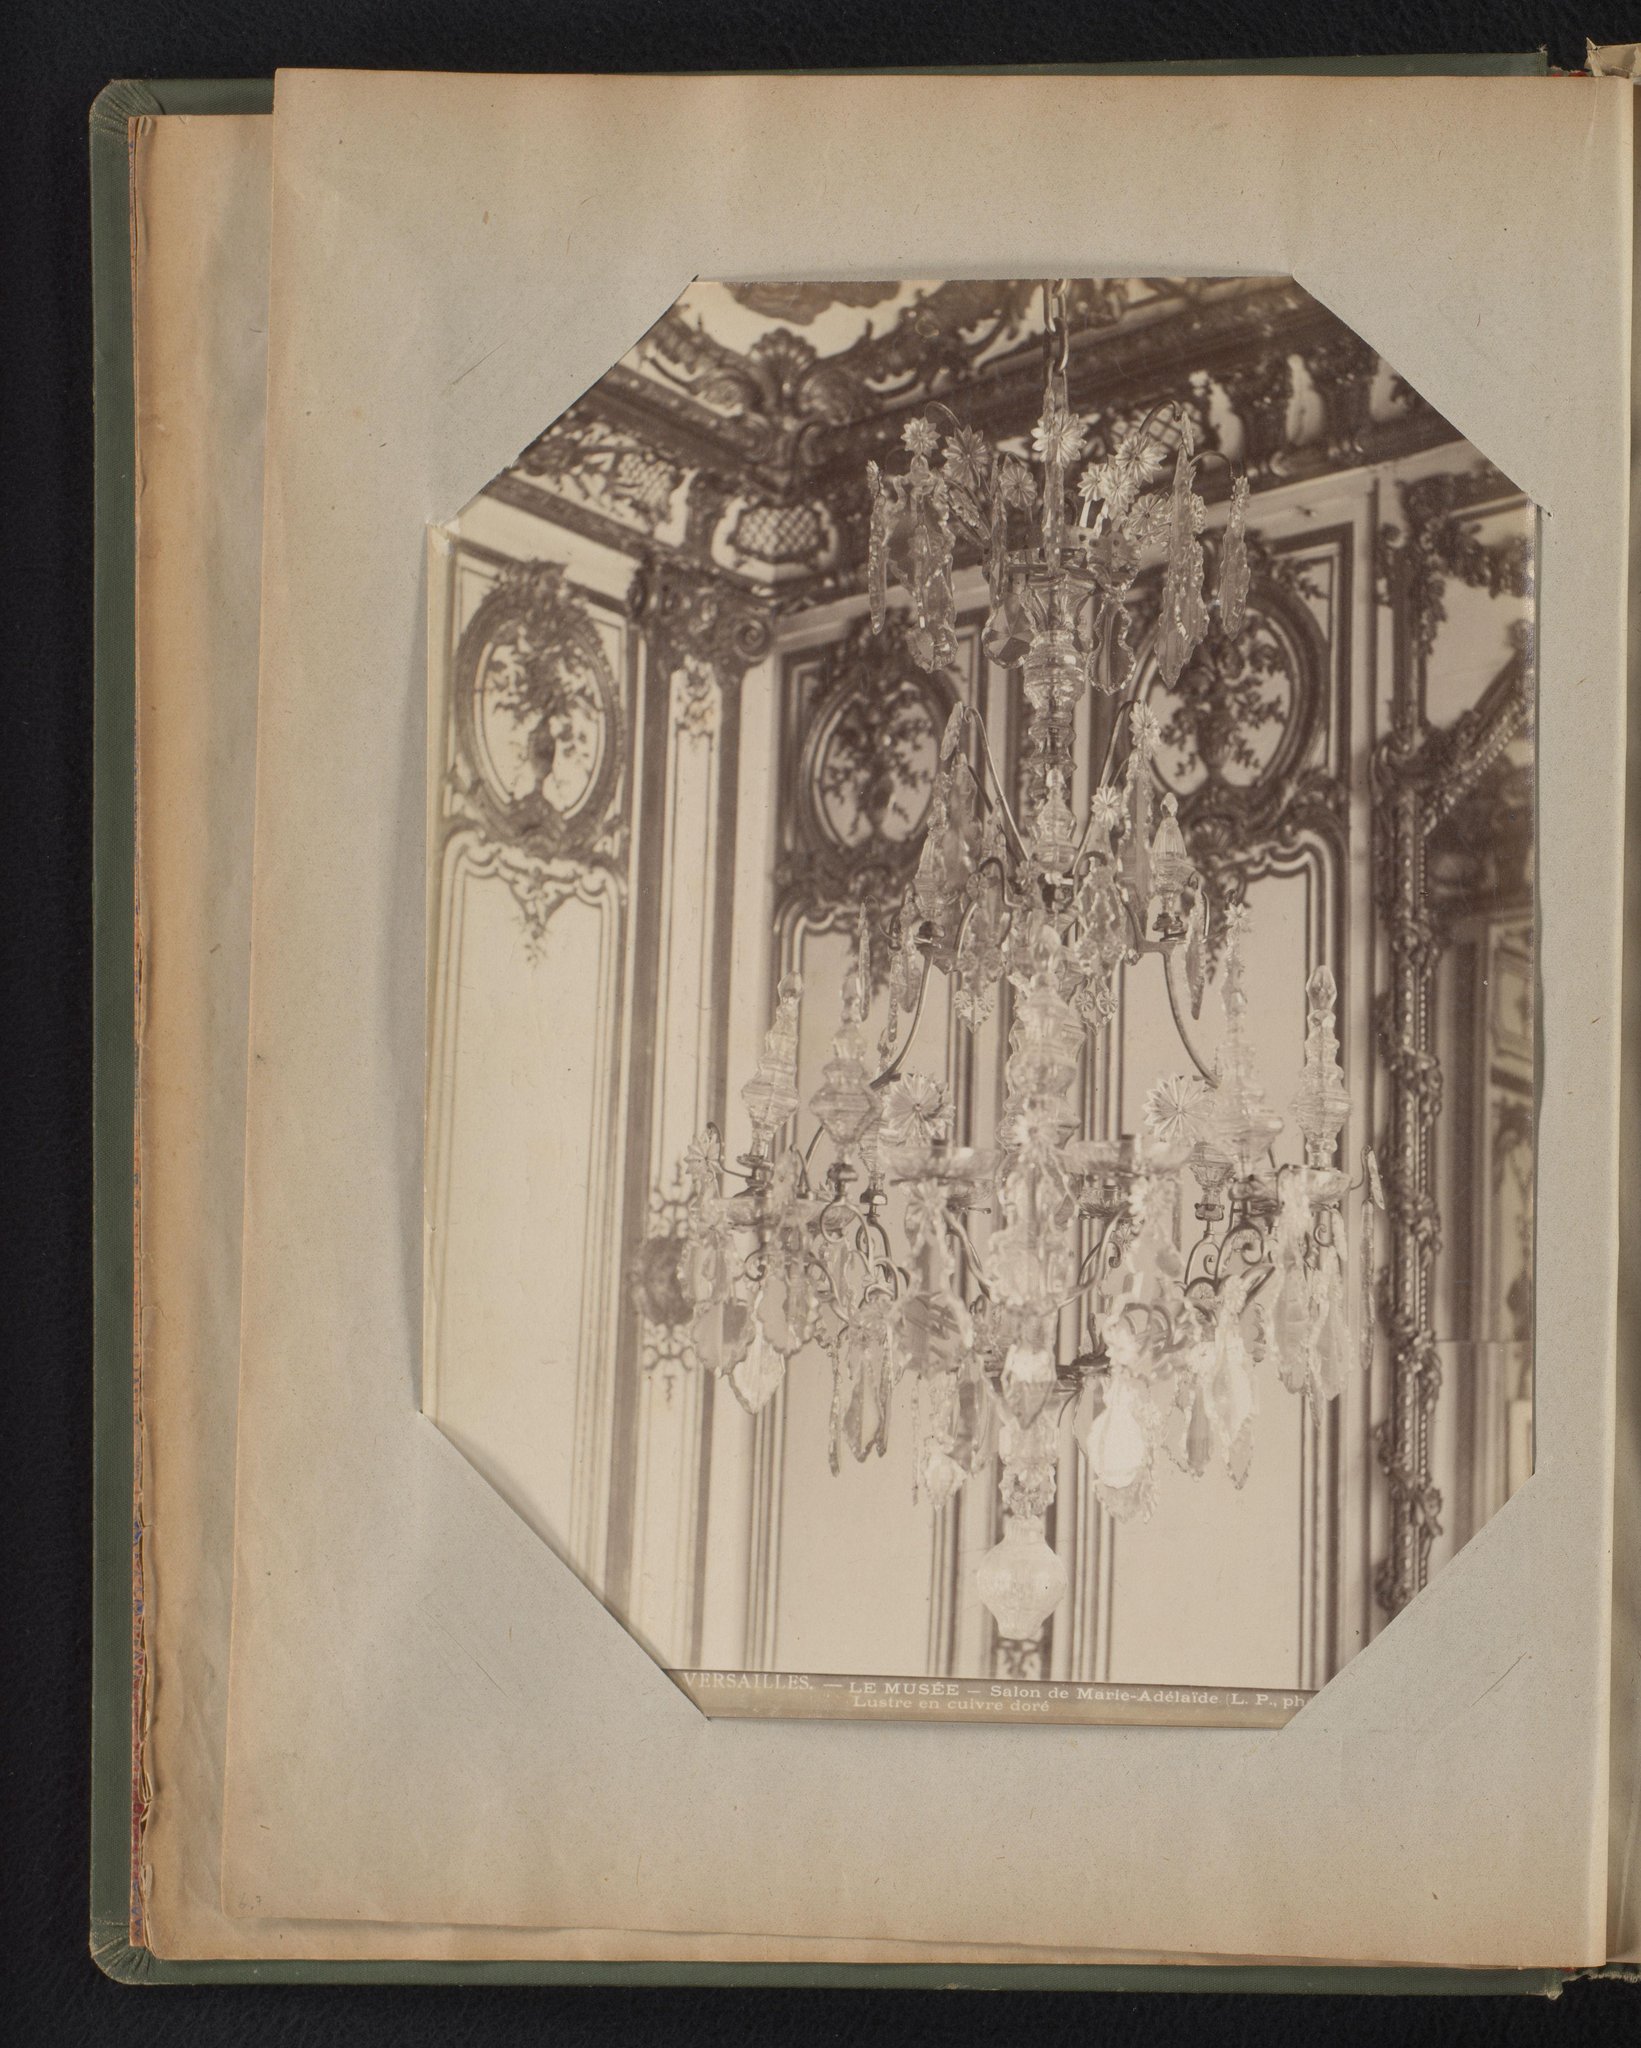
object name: photograph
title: Brons vergulde kroonluchter met kristallen ornamenten in paleis Versailles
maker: Anonymous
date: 1860-1900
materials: canvas, cardboard, paper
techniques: matte daylight collodion silver print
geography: netherlands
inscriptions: annotation: ‘446. - Versailles - Le Musee - Salon de Marie-Adelaide (L.P. Phot) Lustre en cuivre dore.’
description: Foto maakt deel uit van een album met een serie met betrekking tot het interieur van het paleis van Versailles met kroonluchters, deuren, portalen en meubelstukken. Achter deze foto zit RP-F-2005-46-7 gestoken.